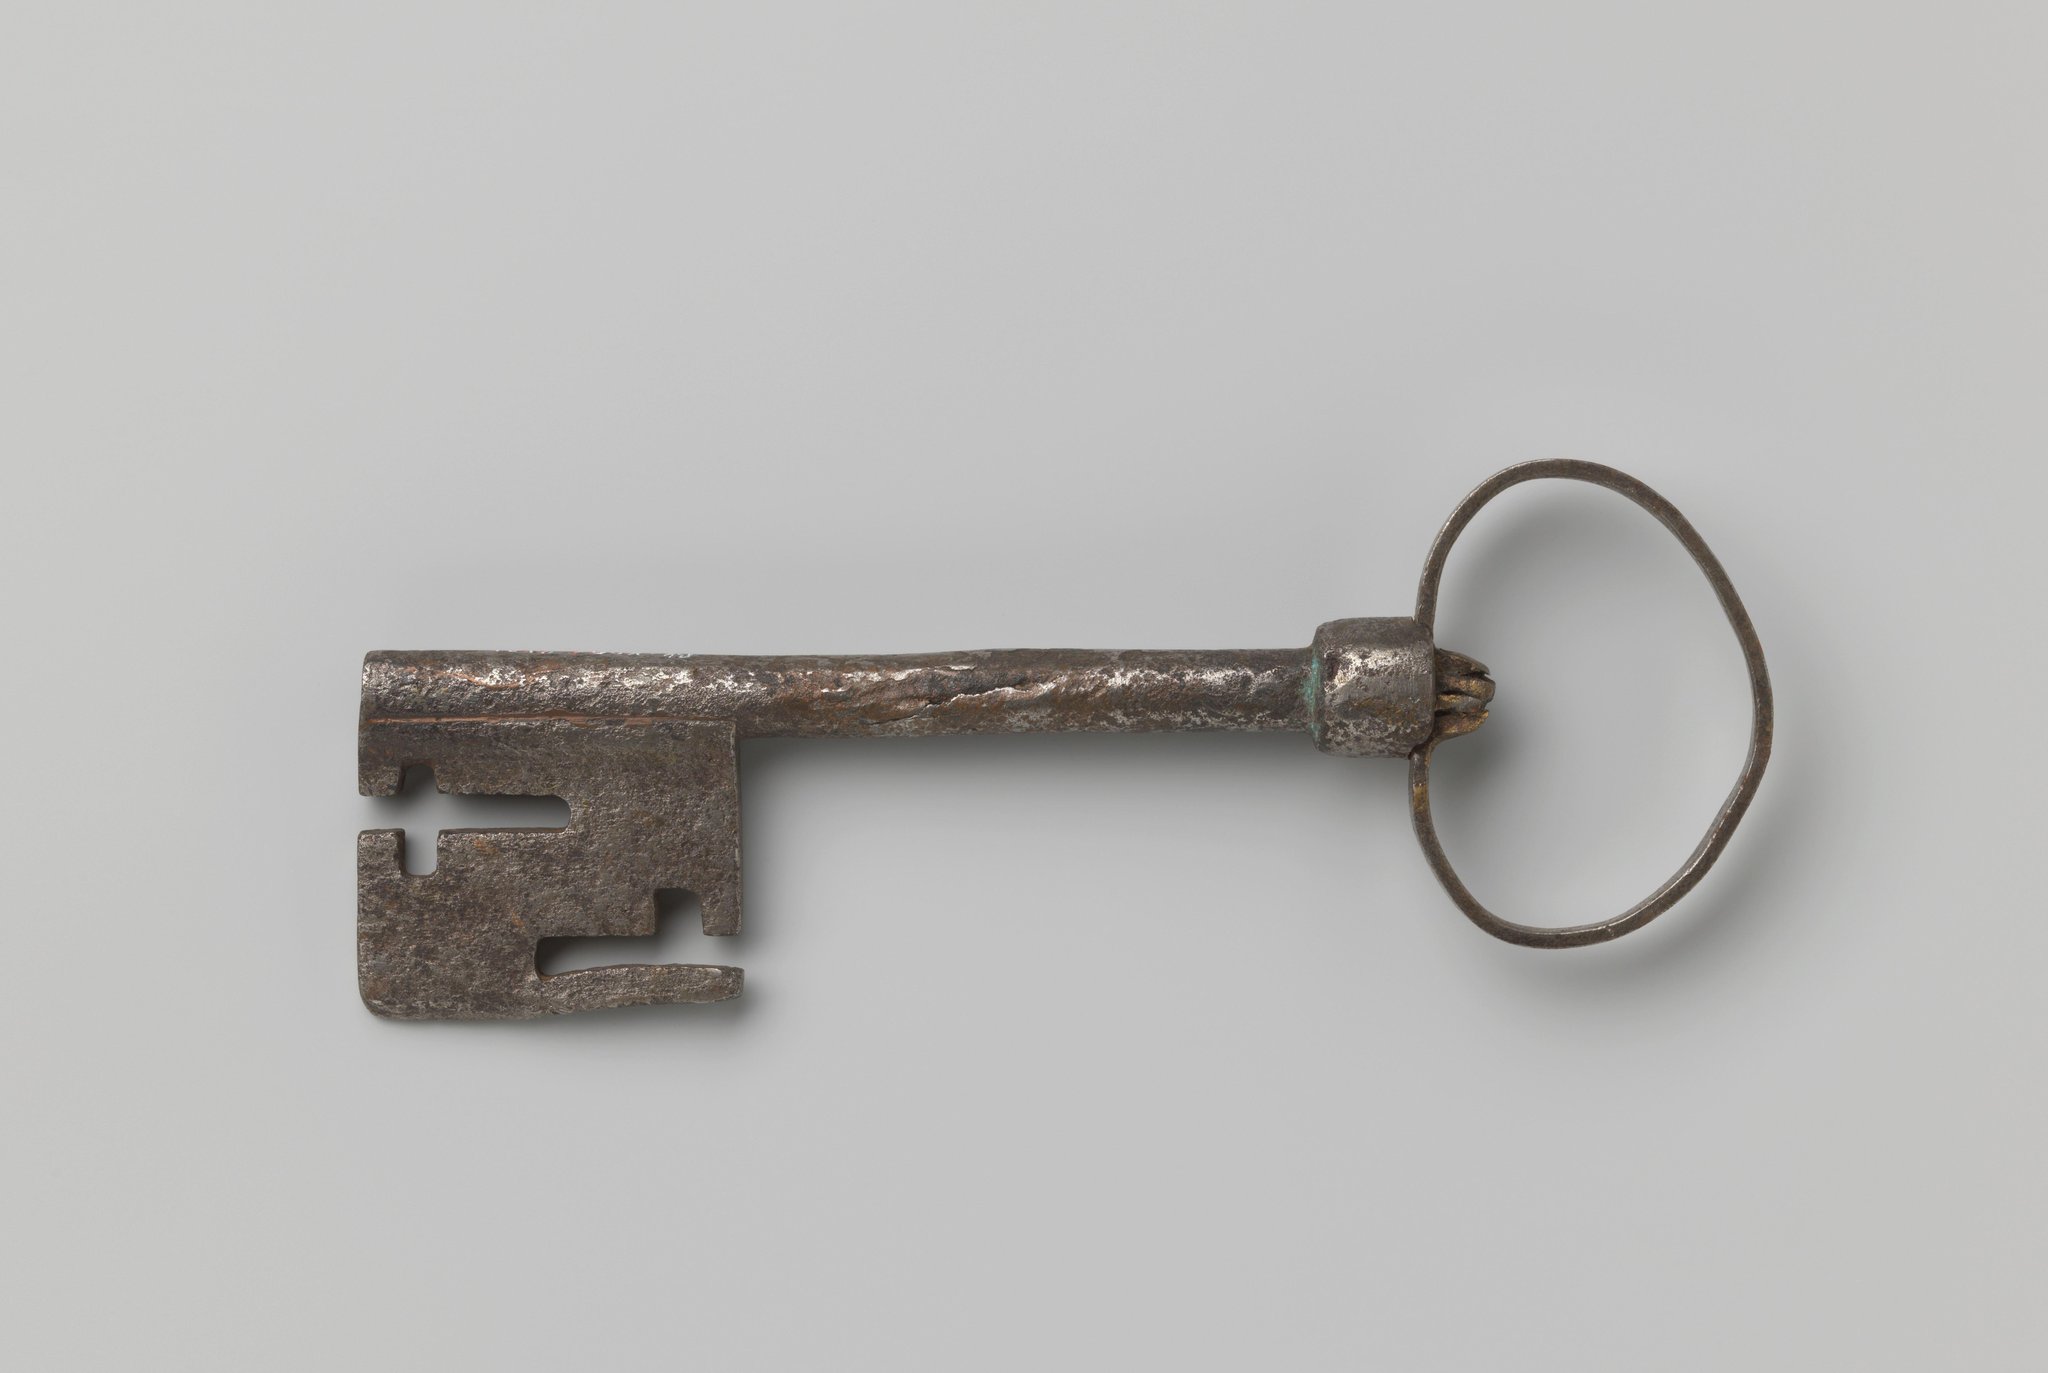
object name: pipe key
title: Pijpsleutel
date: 1400-1500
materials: iron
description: Pijpsleutel waarvan het ovale oog door een ijzeren band gevormd wordt. Onder het oog heeft de schacht een verdikking.